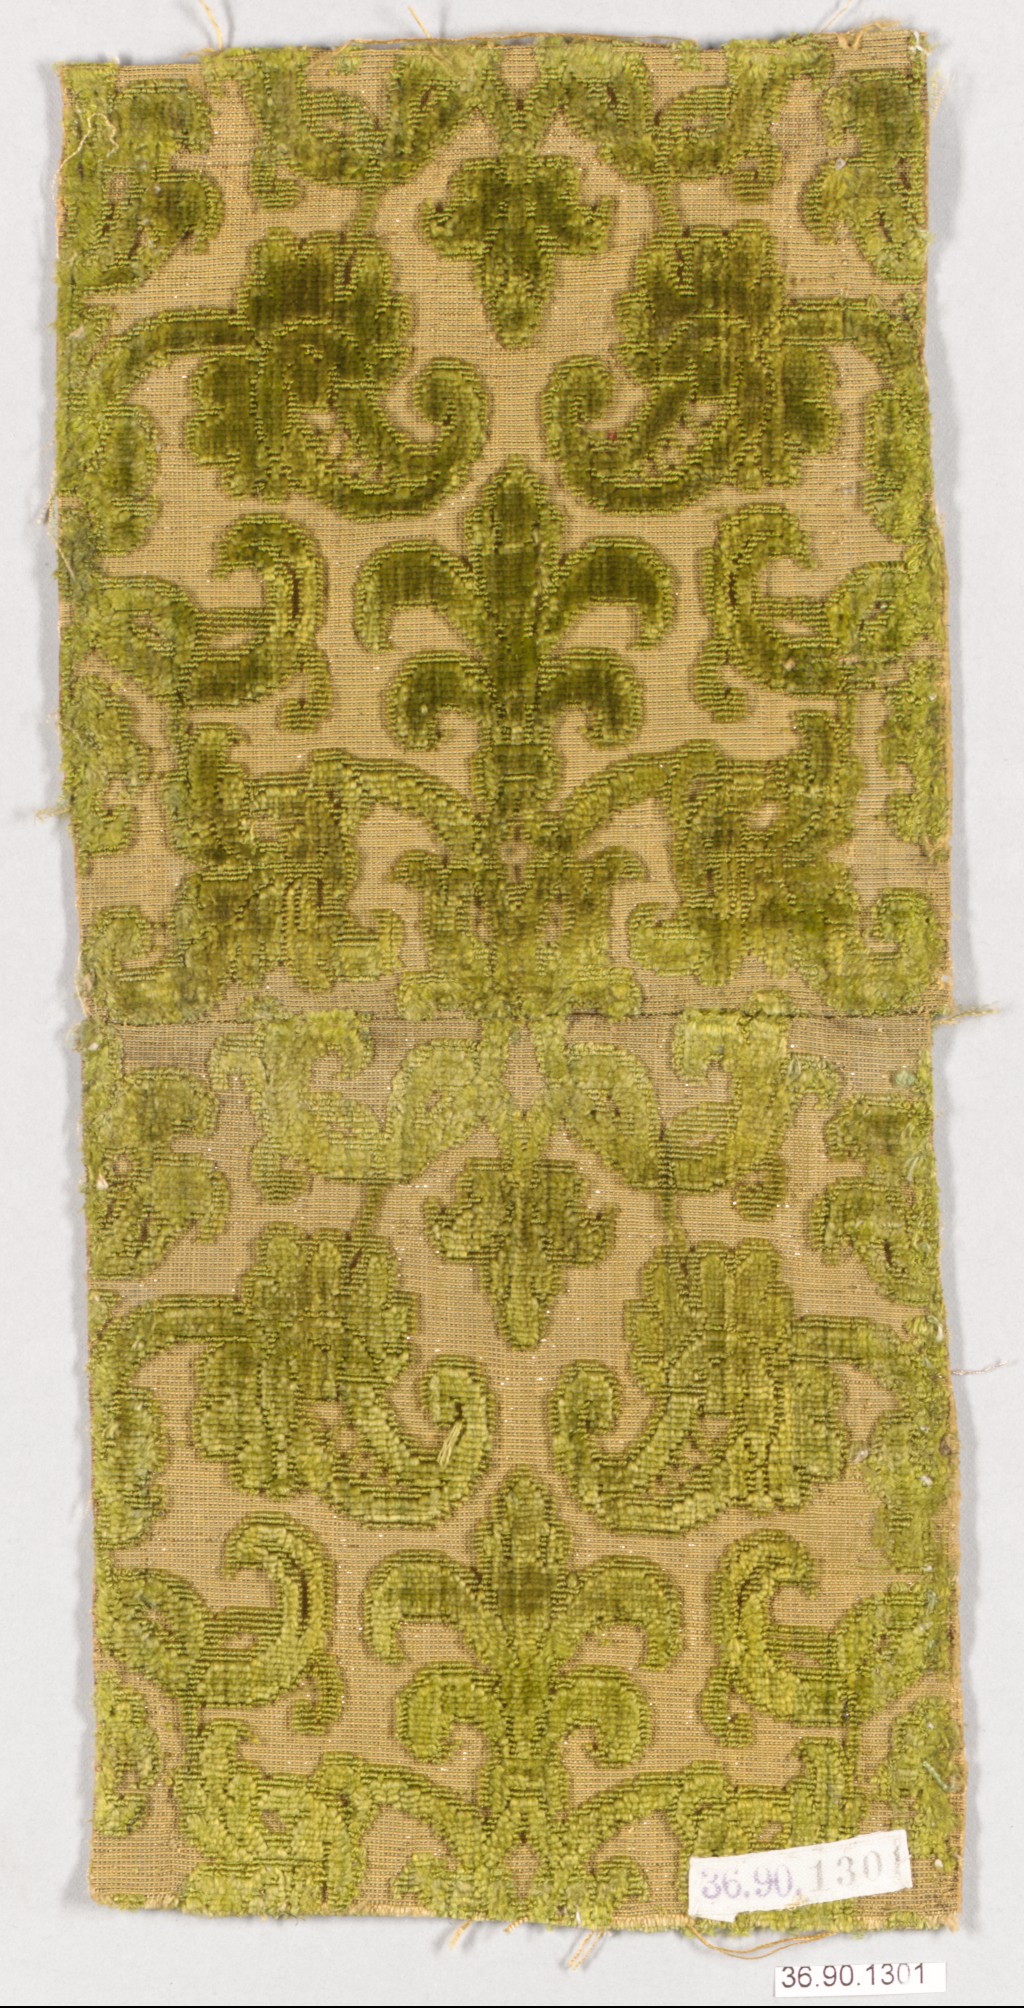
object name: piece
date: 1501-1700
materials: metal thread, silk